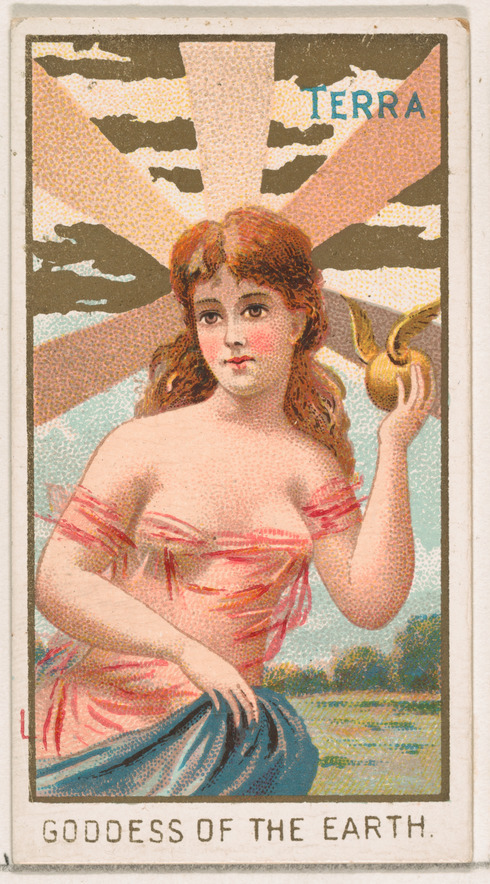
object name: print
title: Terra, Goddess of the Earth, from the Goddesses of the Greeks and Romans series (N188) issued by Wm. S. Kimball & Co.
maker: william s. kimball & company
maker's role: publisher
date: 1889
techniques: color lithograph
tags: goddess